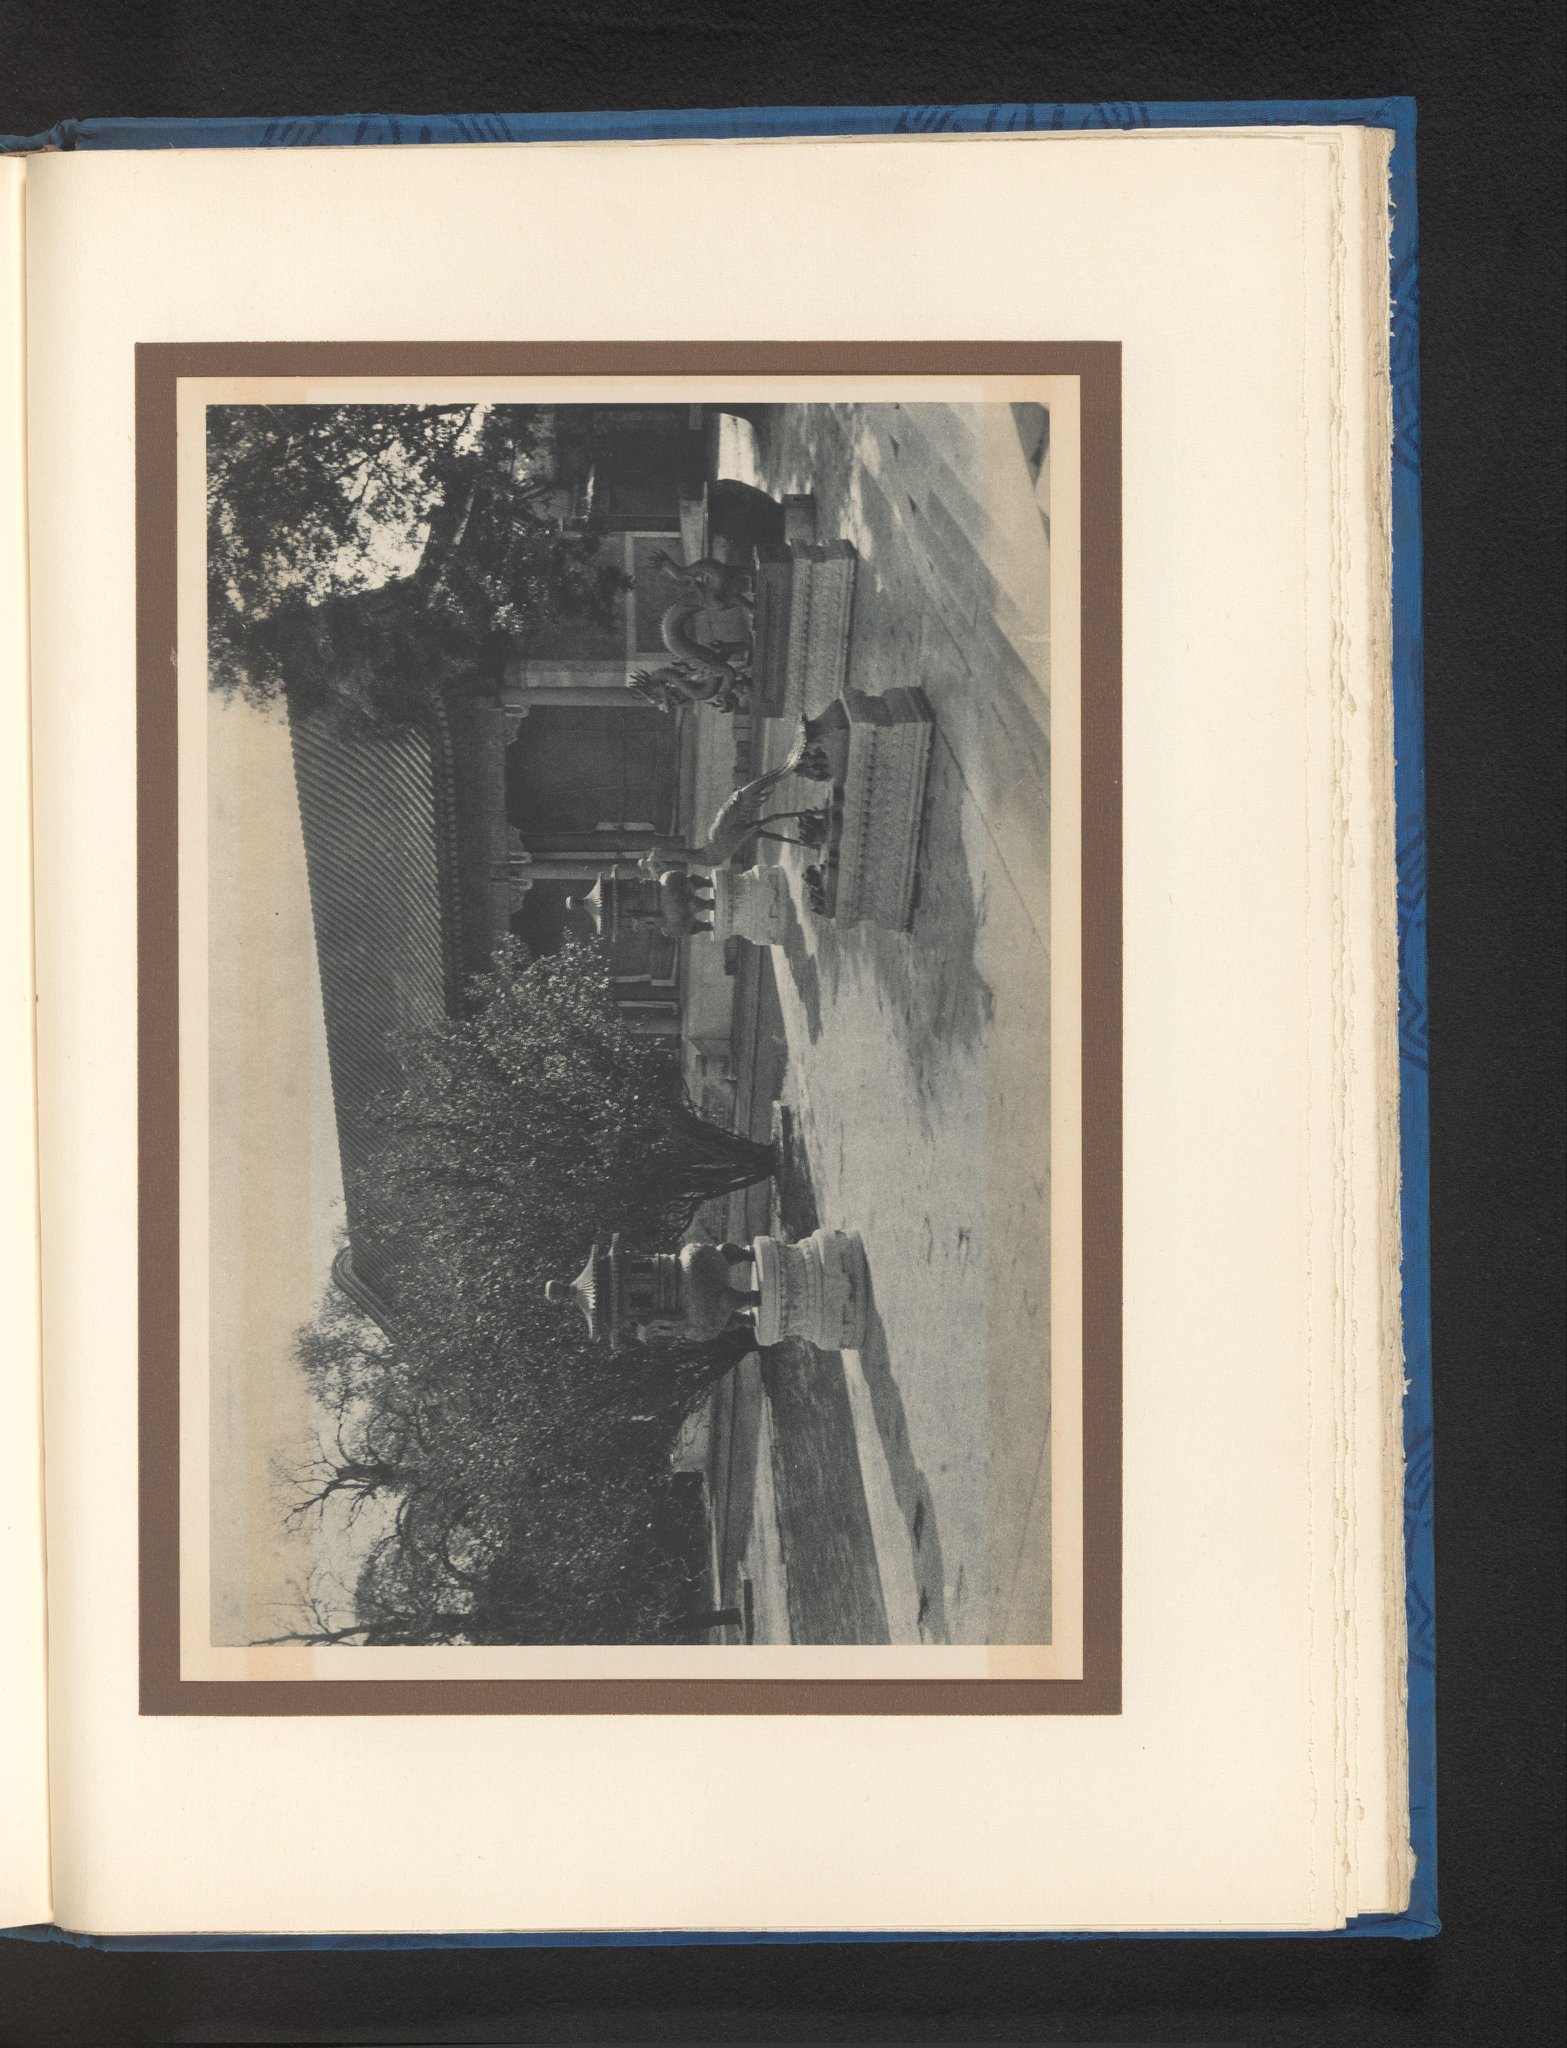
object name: page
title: Bronzen sculpturen bij het Zomerpaleis te Peking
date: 1915-1920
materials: paper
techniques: rotogravure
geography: beijing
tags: palace, sculpture